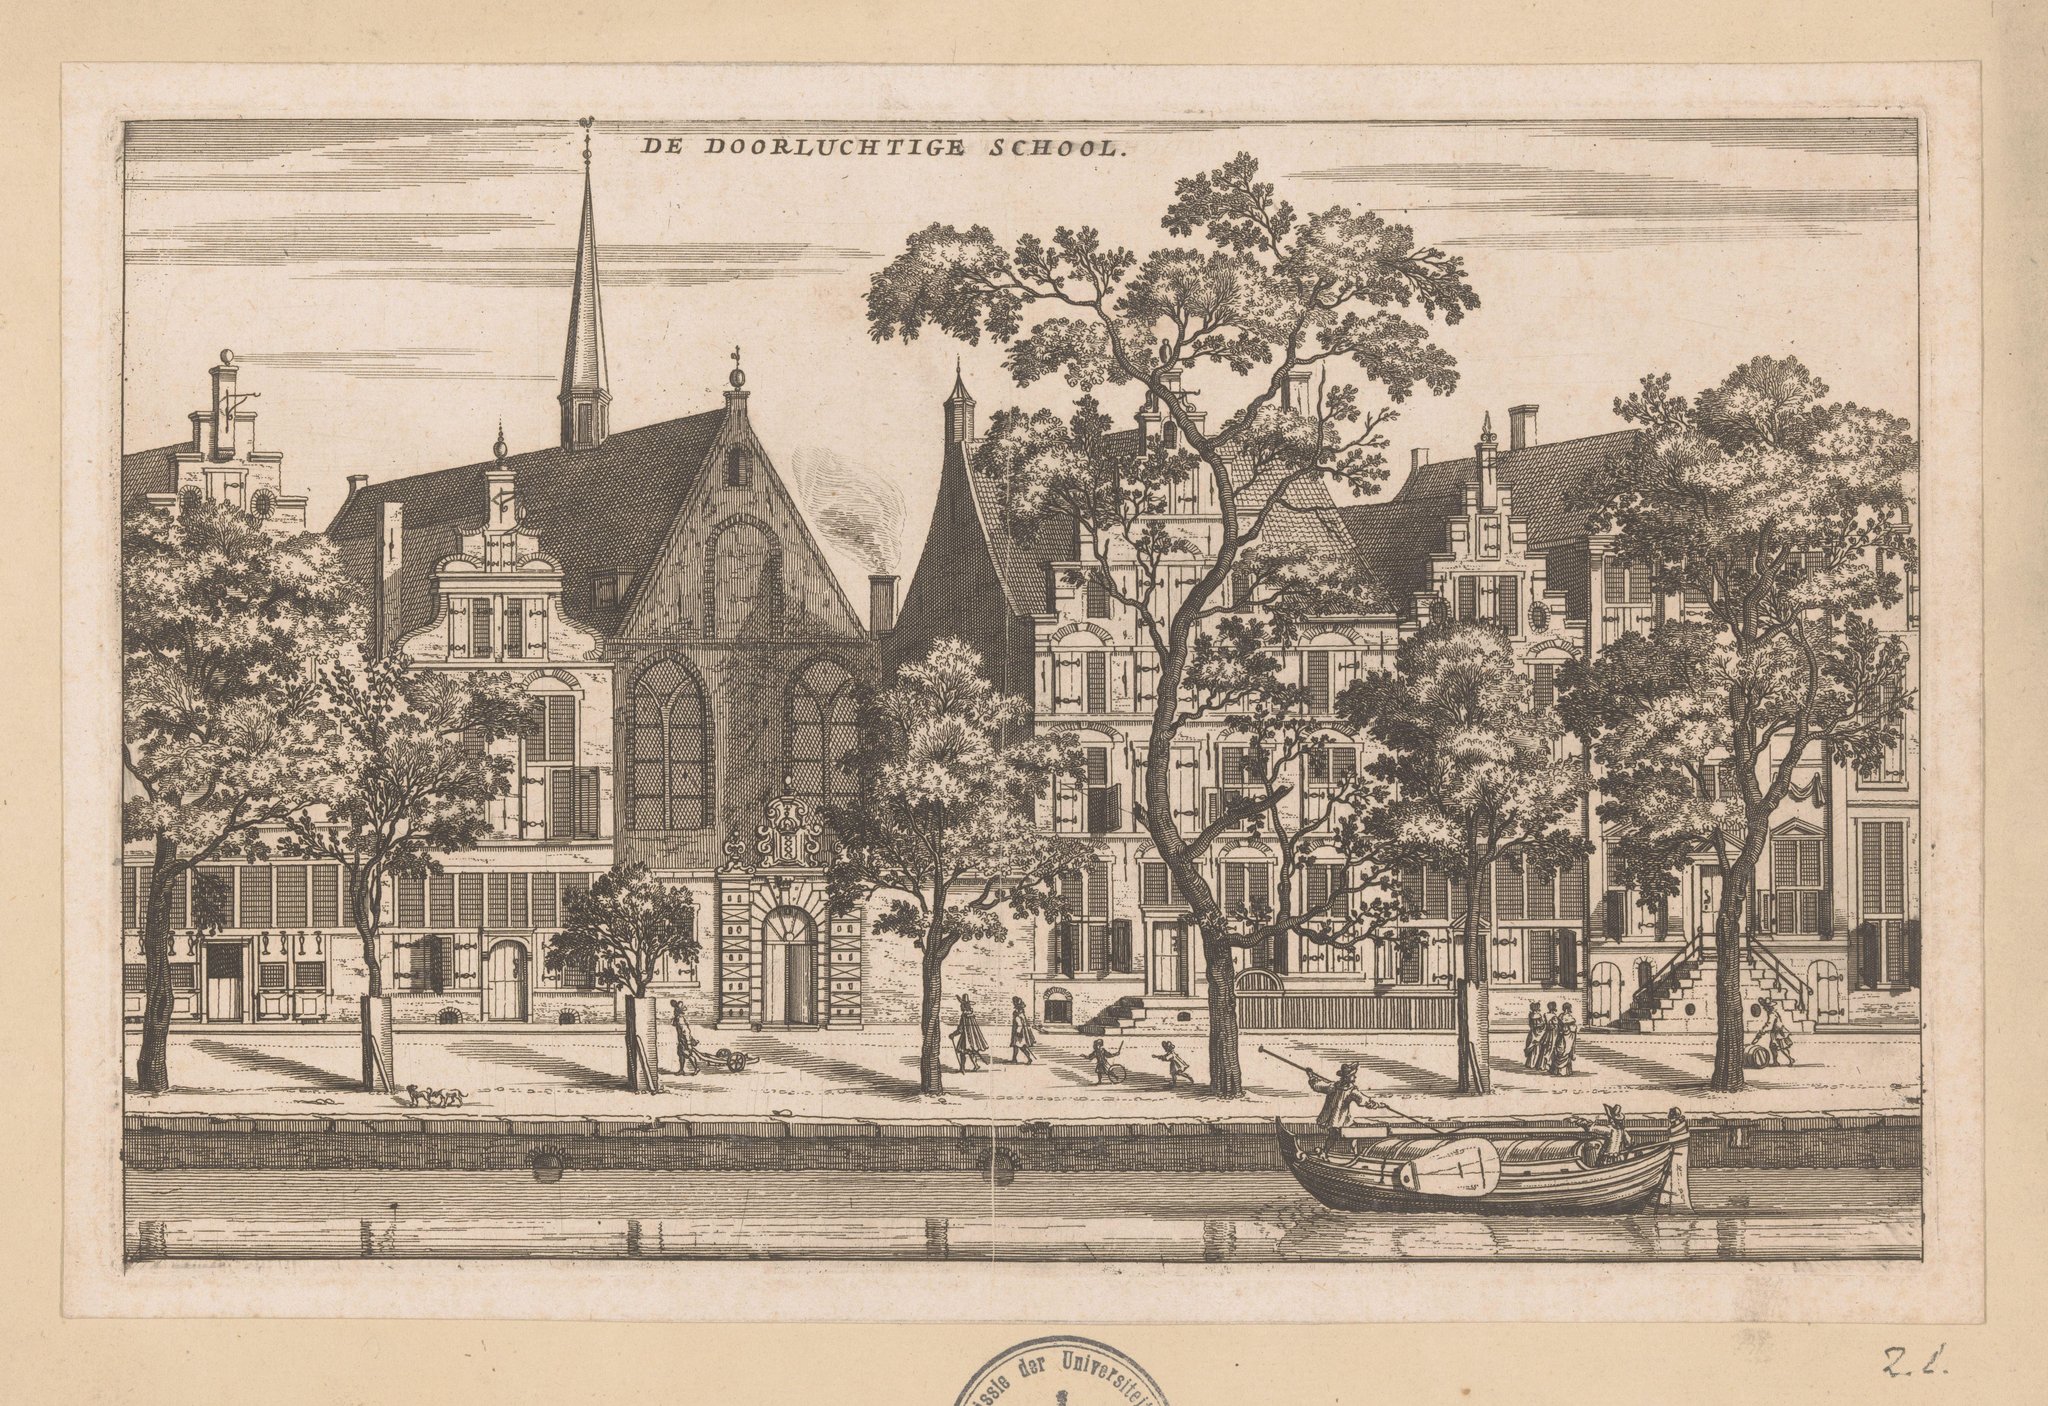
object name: book illustration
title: Gezicht op het Athenaeum Illustre te Amsterdam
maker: Anonymous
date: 1663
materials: paper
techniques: etching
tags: names of organizations, companies, trade unions, etc., poling, punting, canals, waters (in city), university building, college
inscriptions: collector's mark: ‘Historische Commissie der Universiteit van Amsterdam’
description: Prent uit: Dapper, Olfert. Historische beschryving der stadt Amsterdam (...). Amsterdam: Jacob van Meurs, 1663, p. 439. En uit: Zesen, Philip von. Beschreibung der Stadt Amsterdam (...). Amsterdam: Joachim Nosche, 1664, p. 332-333.